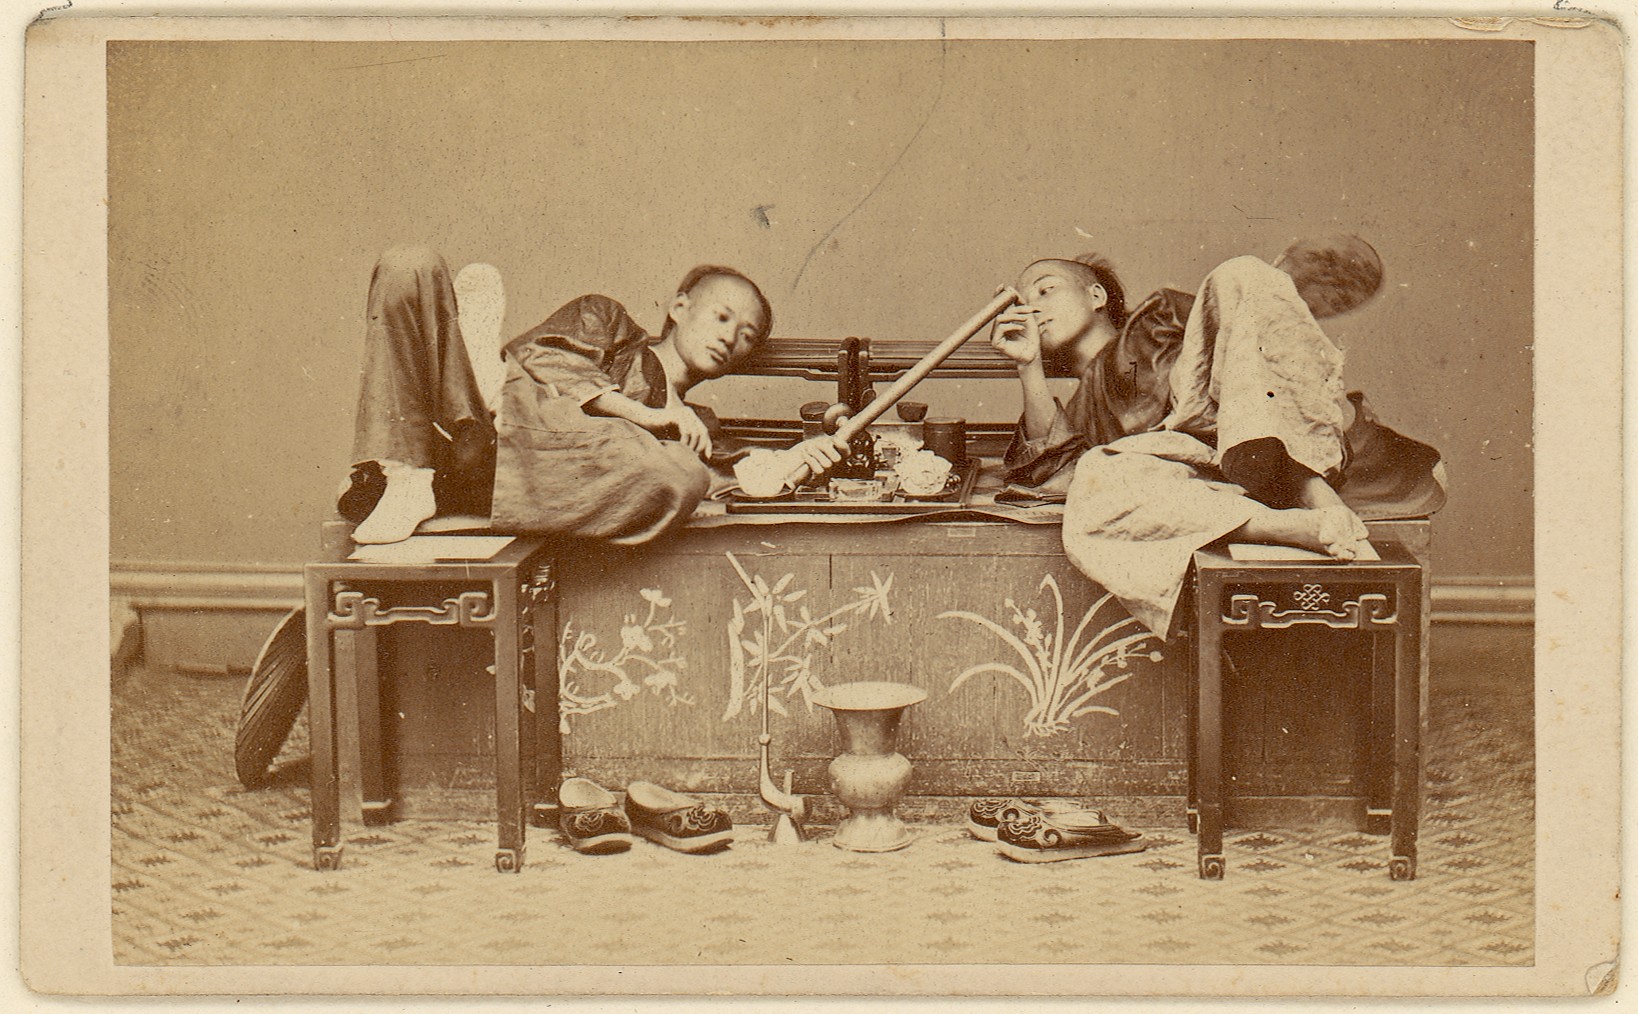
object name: carte de visite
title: [Opium Smokers]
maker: pun-lun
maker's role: artist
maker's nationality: chinese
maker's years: 1864-1900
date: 1870-1879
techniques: albumen silver print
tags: men,smoking